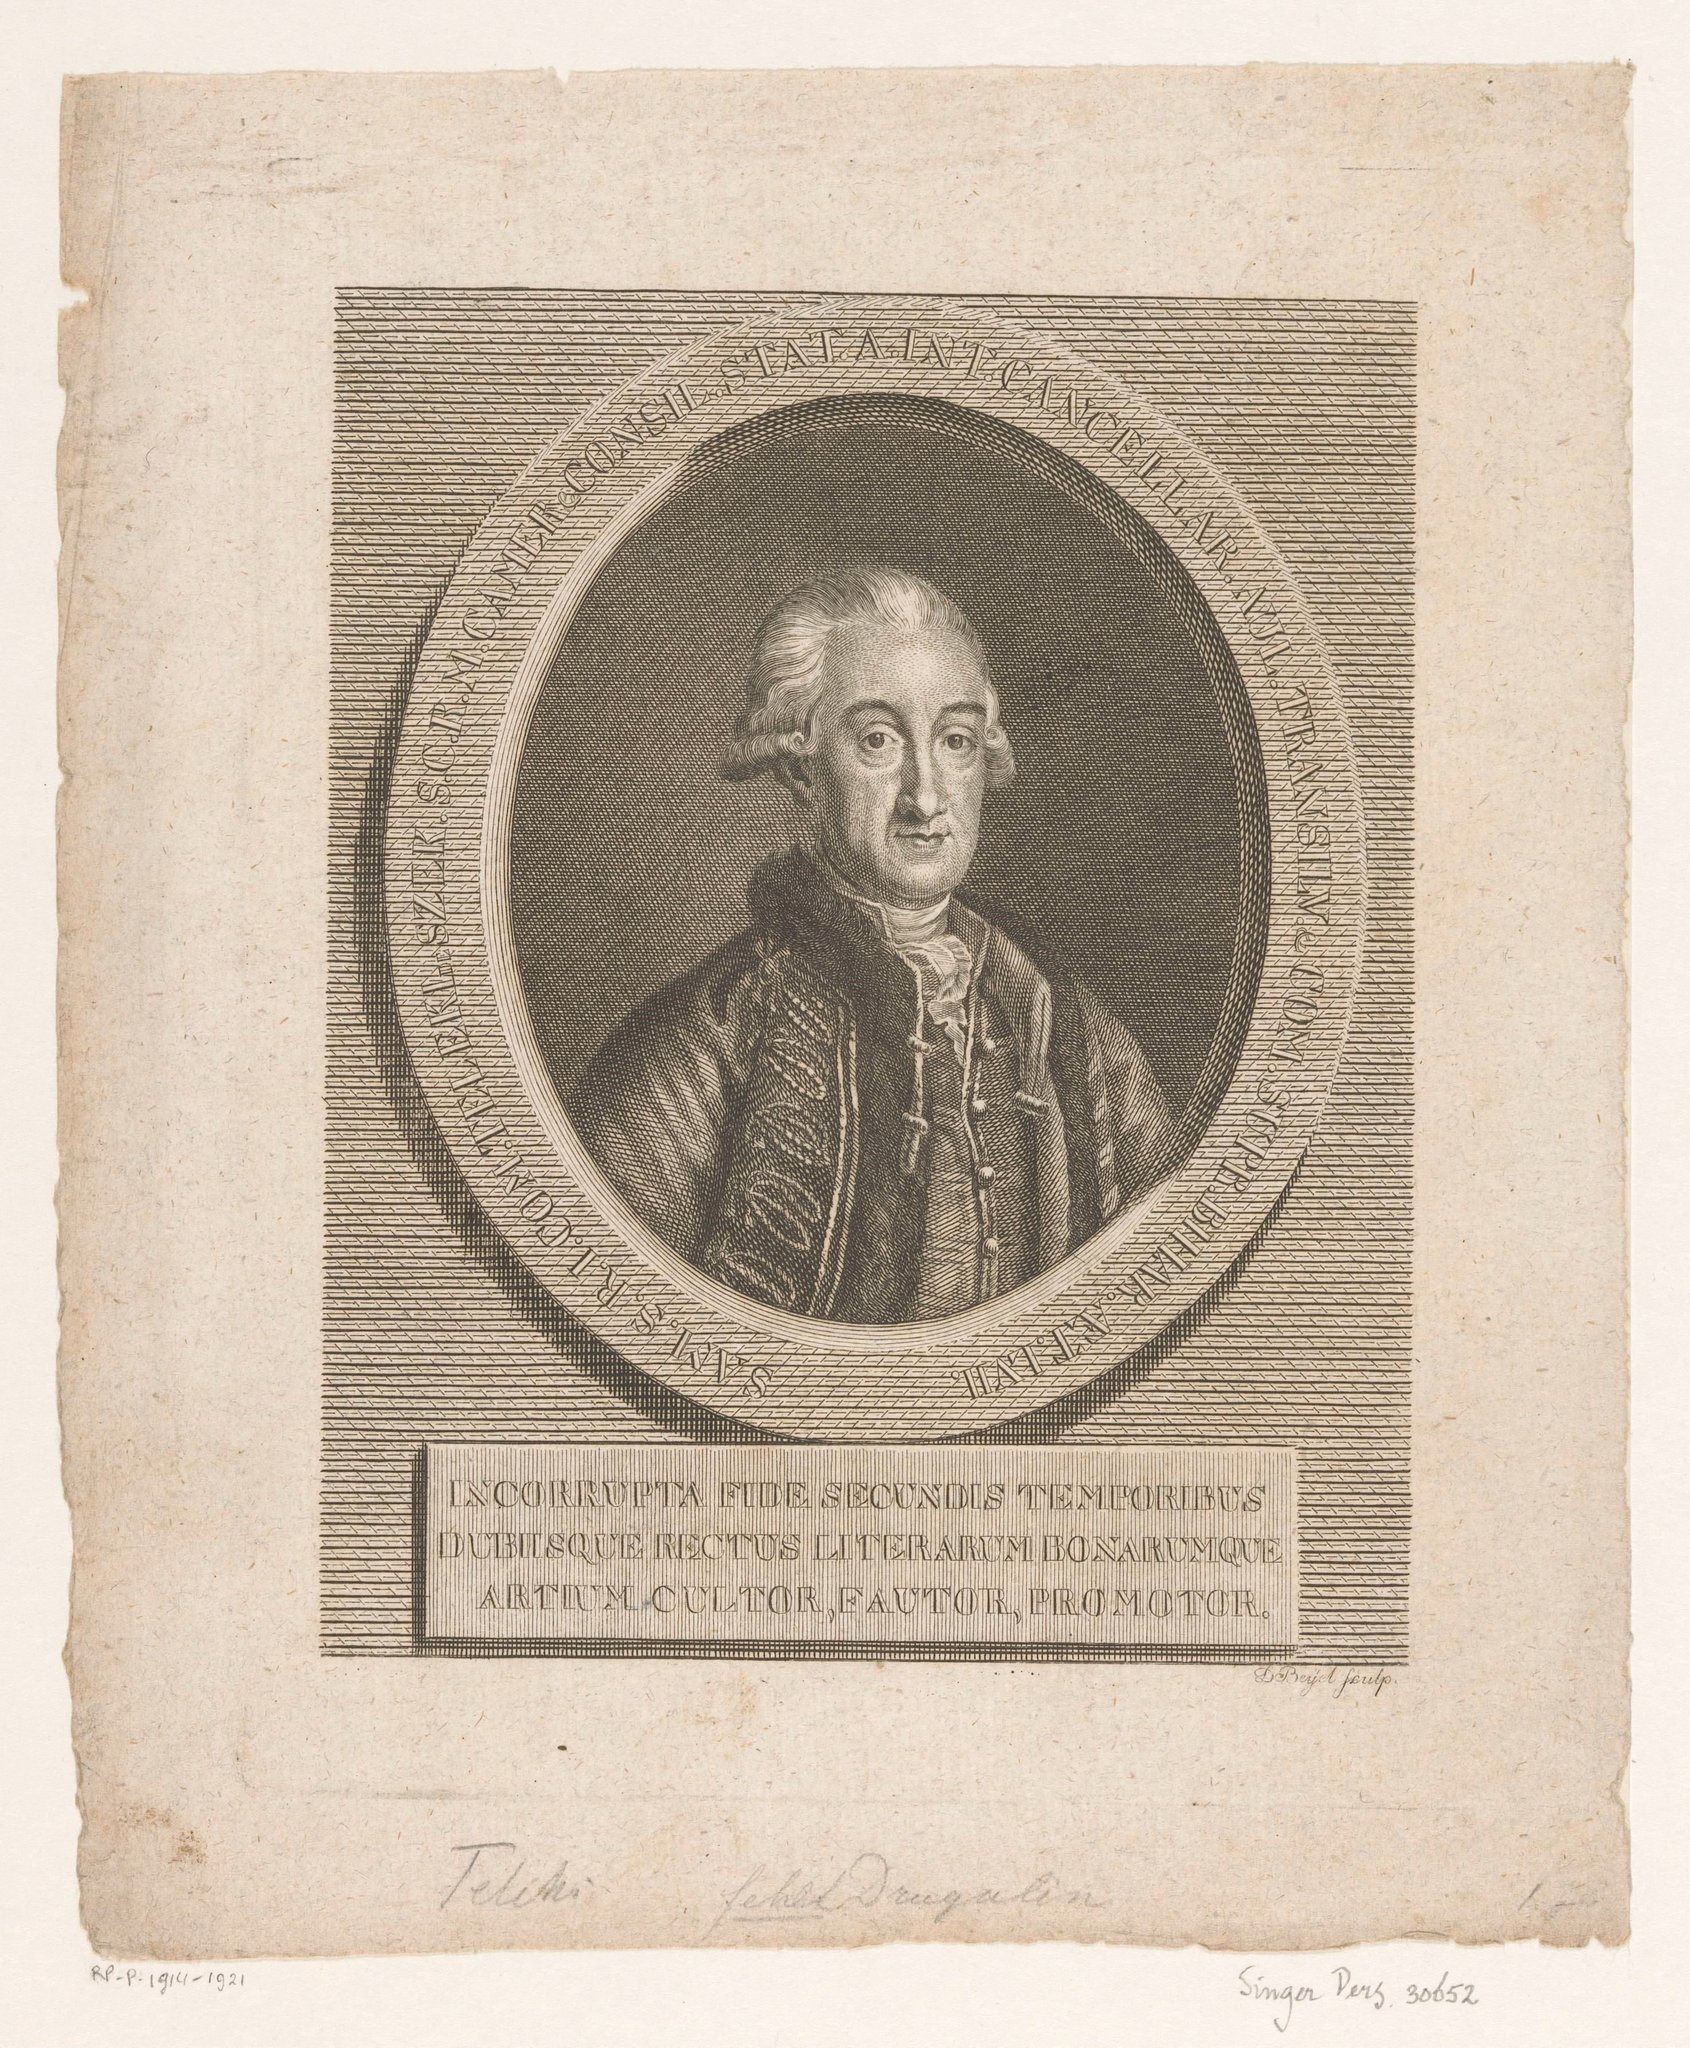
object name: print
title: Samuel Teleki von Szek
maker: daniel beyel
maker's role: draughtsman, print maker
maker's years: 1760-1823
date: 1785-1823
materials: paper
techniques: engraving, etching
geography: munich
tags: vienna, historical persons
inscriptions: collector's mark: Lugt 2228